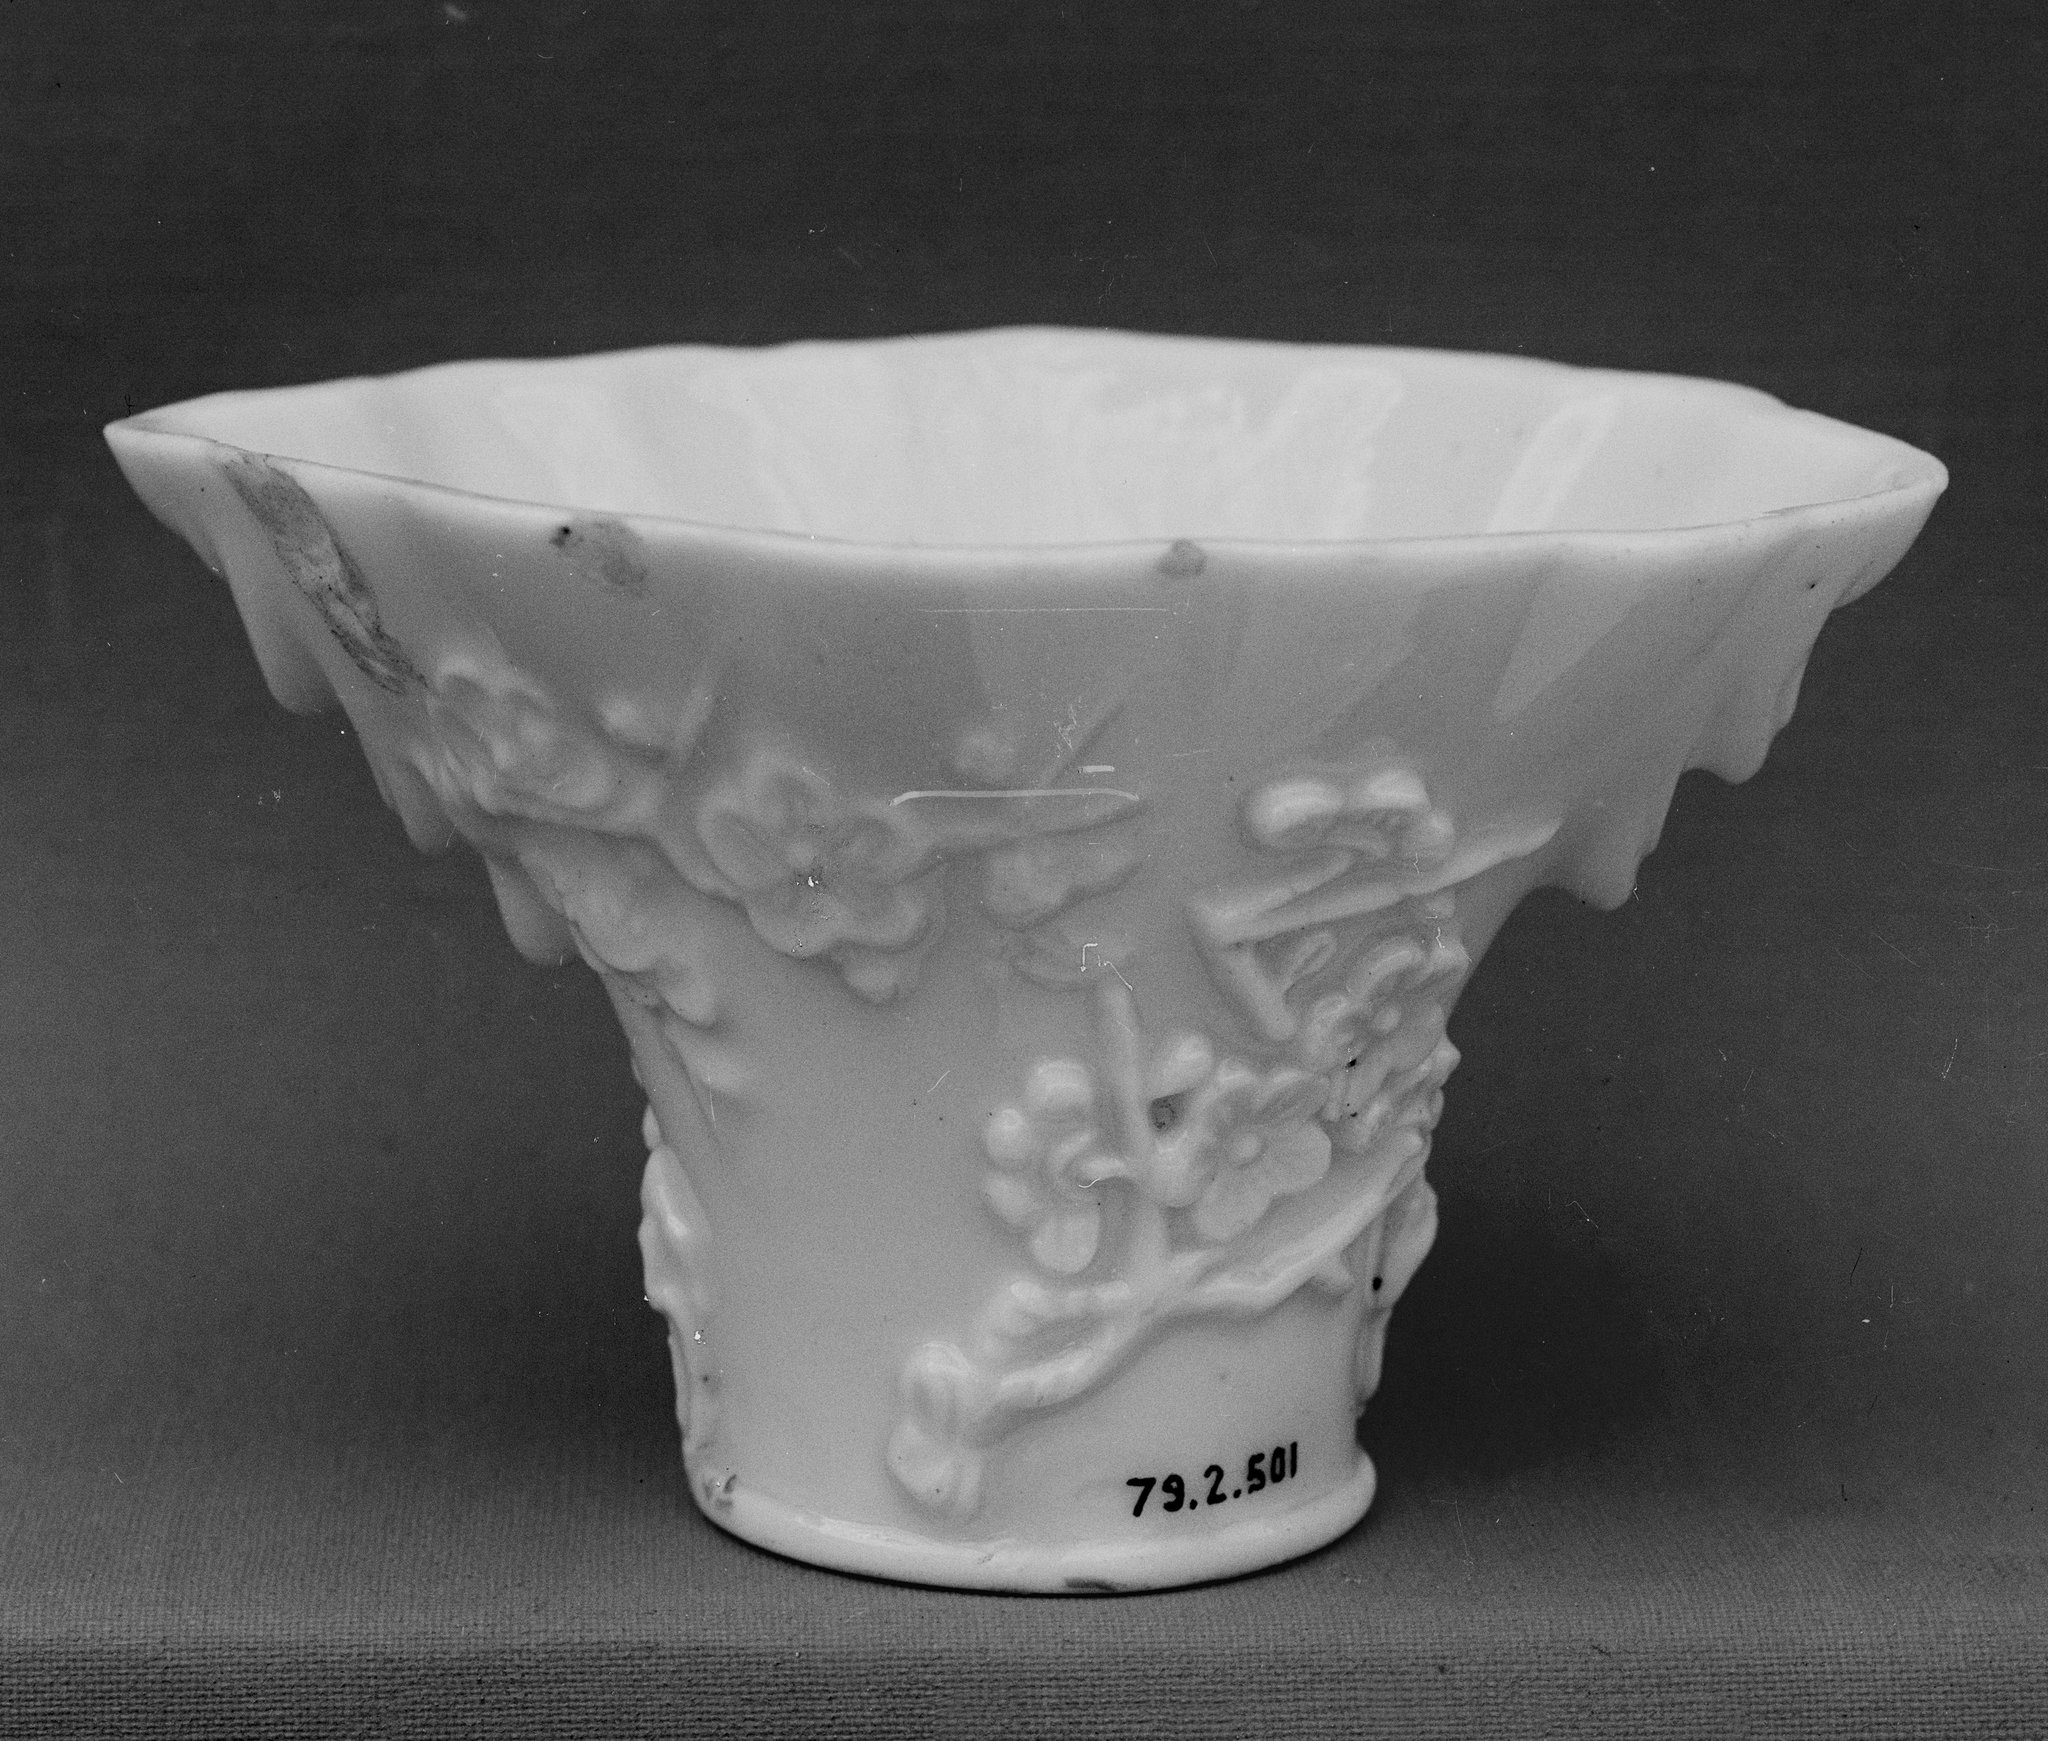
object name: cup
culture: chinese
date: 1667-1733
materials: glaze, porcelain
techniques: relief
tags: flowers